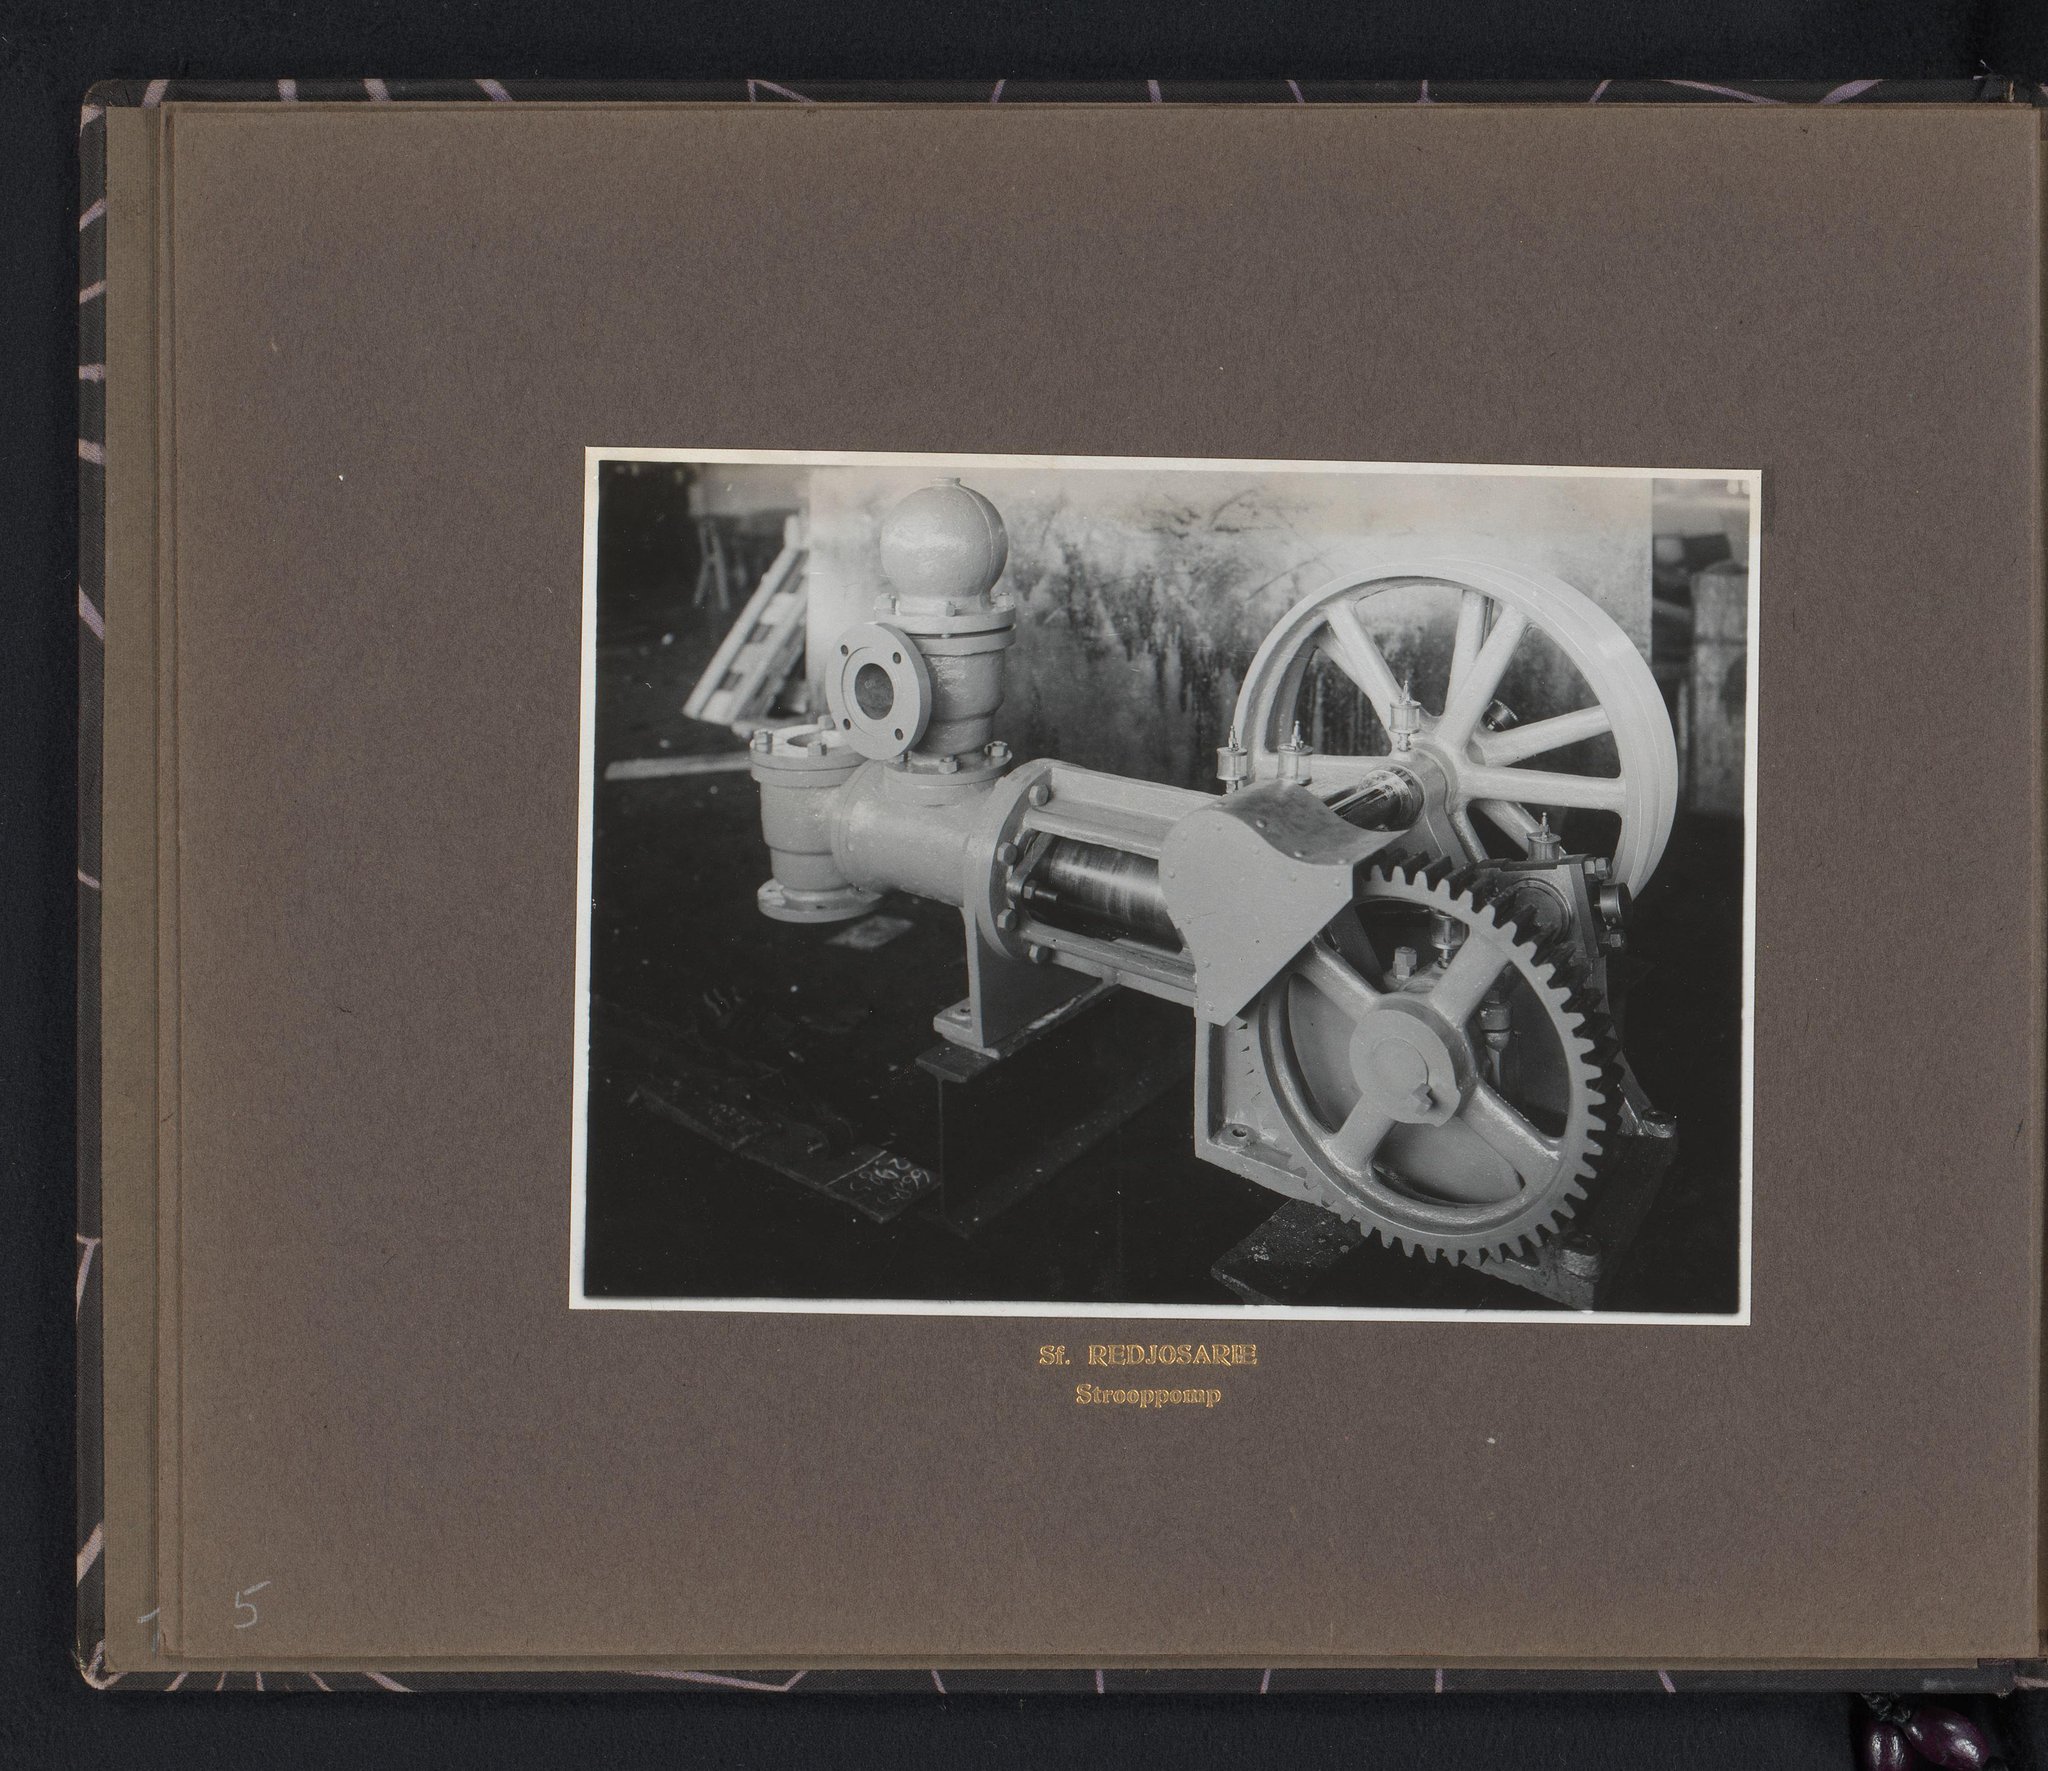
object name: photograph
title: Sf. Redjosarie Strooppomp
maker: Anonymous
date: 1916-1924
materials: cardboard, photographic support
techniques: gelatin silver print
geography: surabaya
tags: colonial system, factory-interior, machine shop, machines; parts of machines; tools and appliances, java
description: Albumblad met een foto van een pomp. Vervaardigd door Machinefabriek Braat en bestemd voor de Suikerfabriek Redjosari. Onderdeel van het fotoalbum Machinefabriek Braat Soerabaia-Djocja-Tegal, ca. 1916-1924.